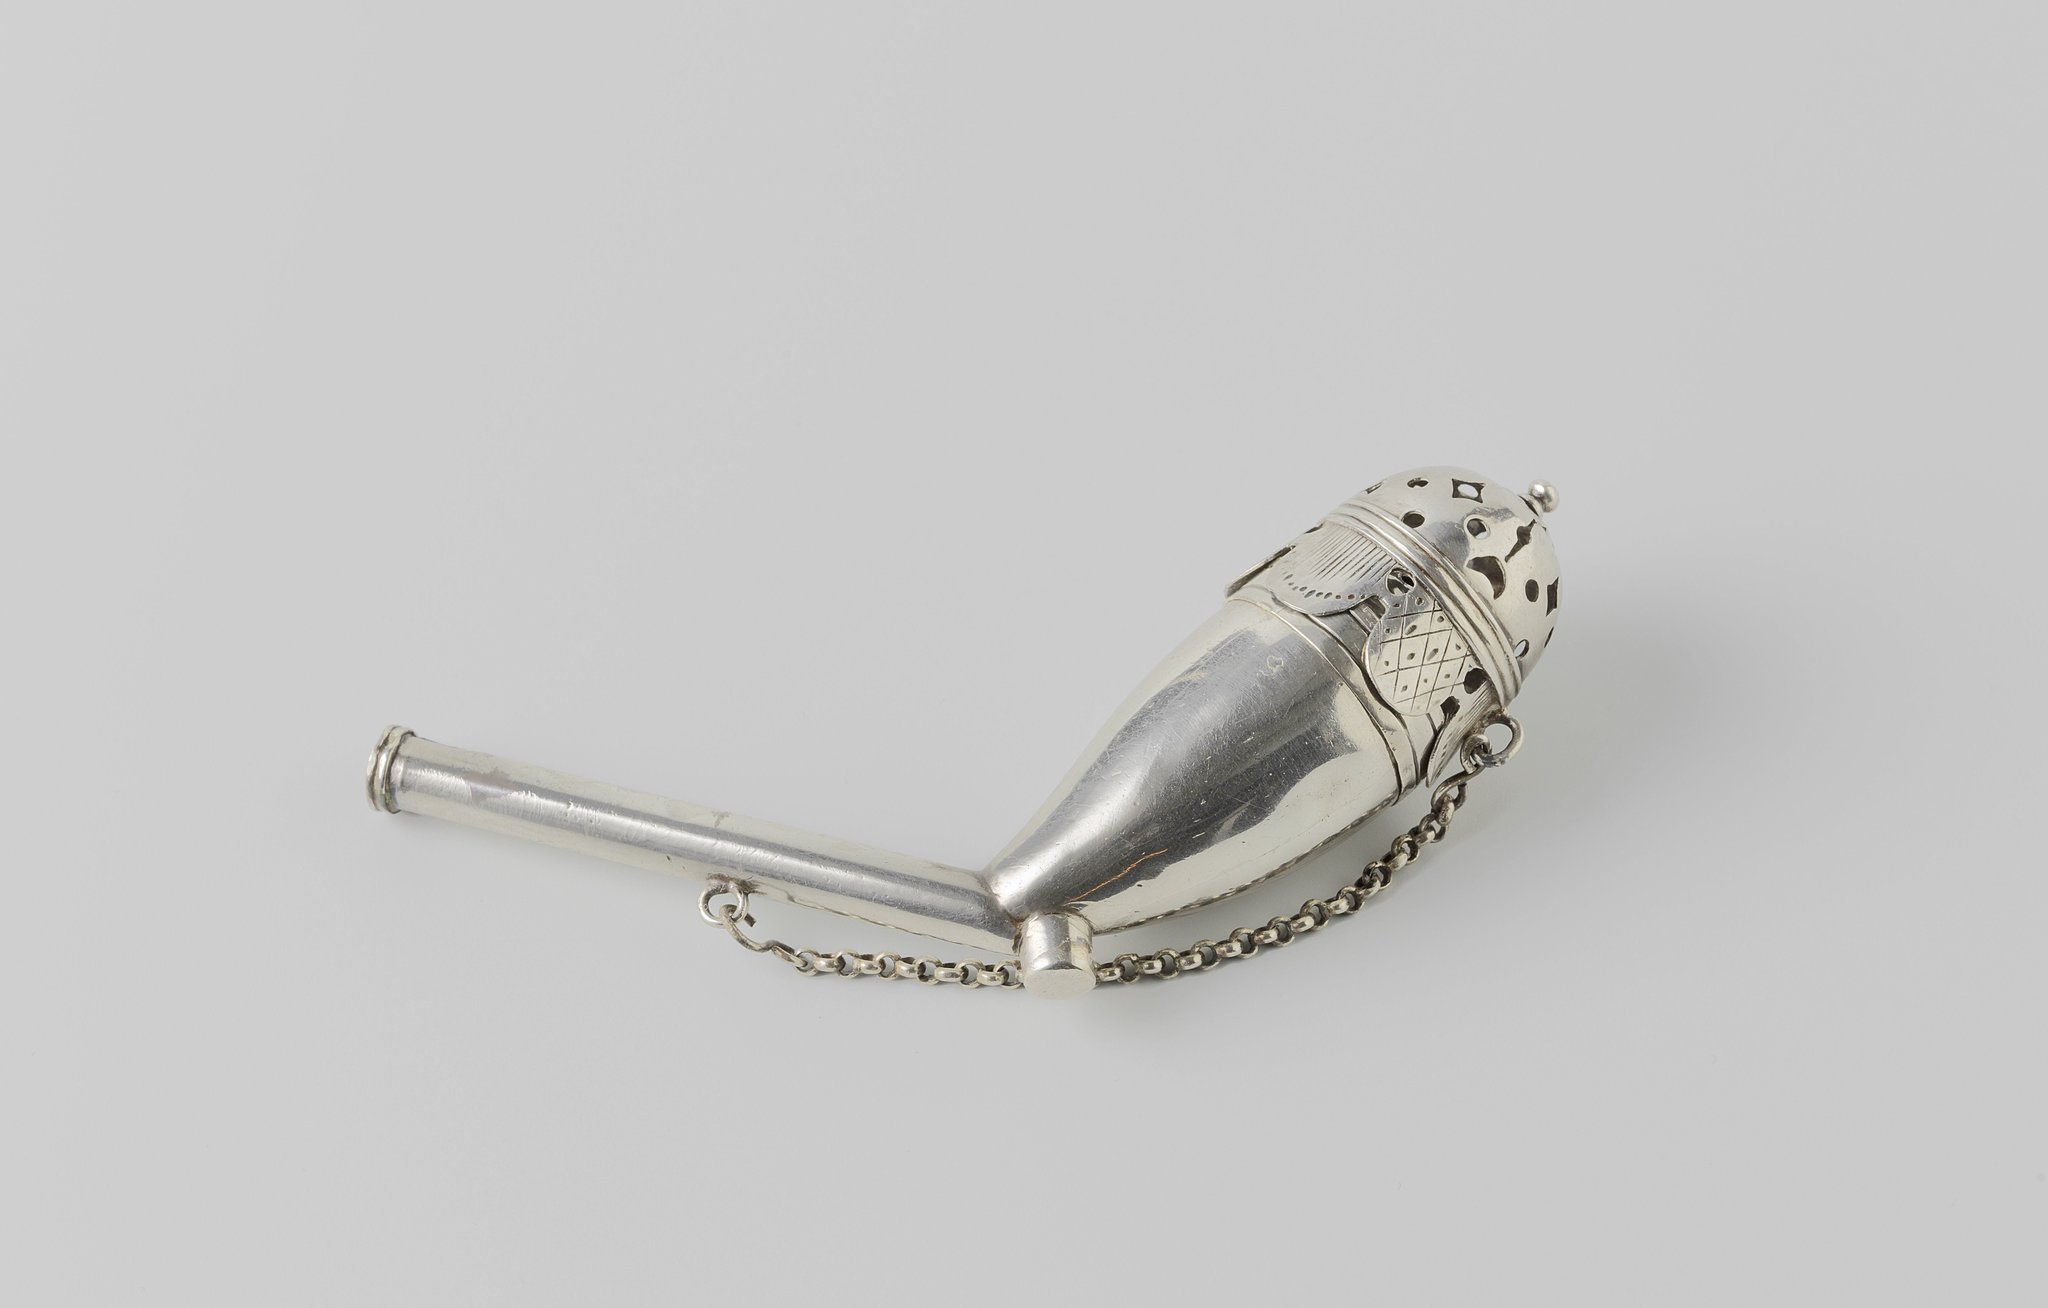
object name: pipe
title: Pijp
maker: Anonymous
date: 1700-1800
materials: wood, silver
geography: netherlands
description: Pijp van zilver met dop. De dop is opengewerkt. De helft van de steel is van ebbenhout (steel niet meer aanwezig zinds 1960 ?).